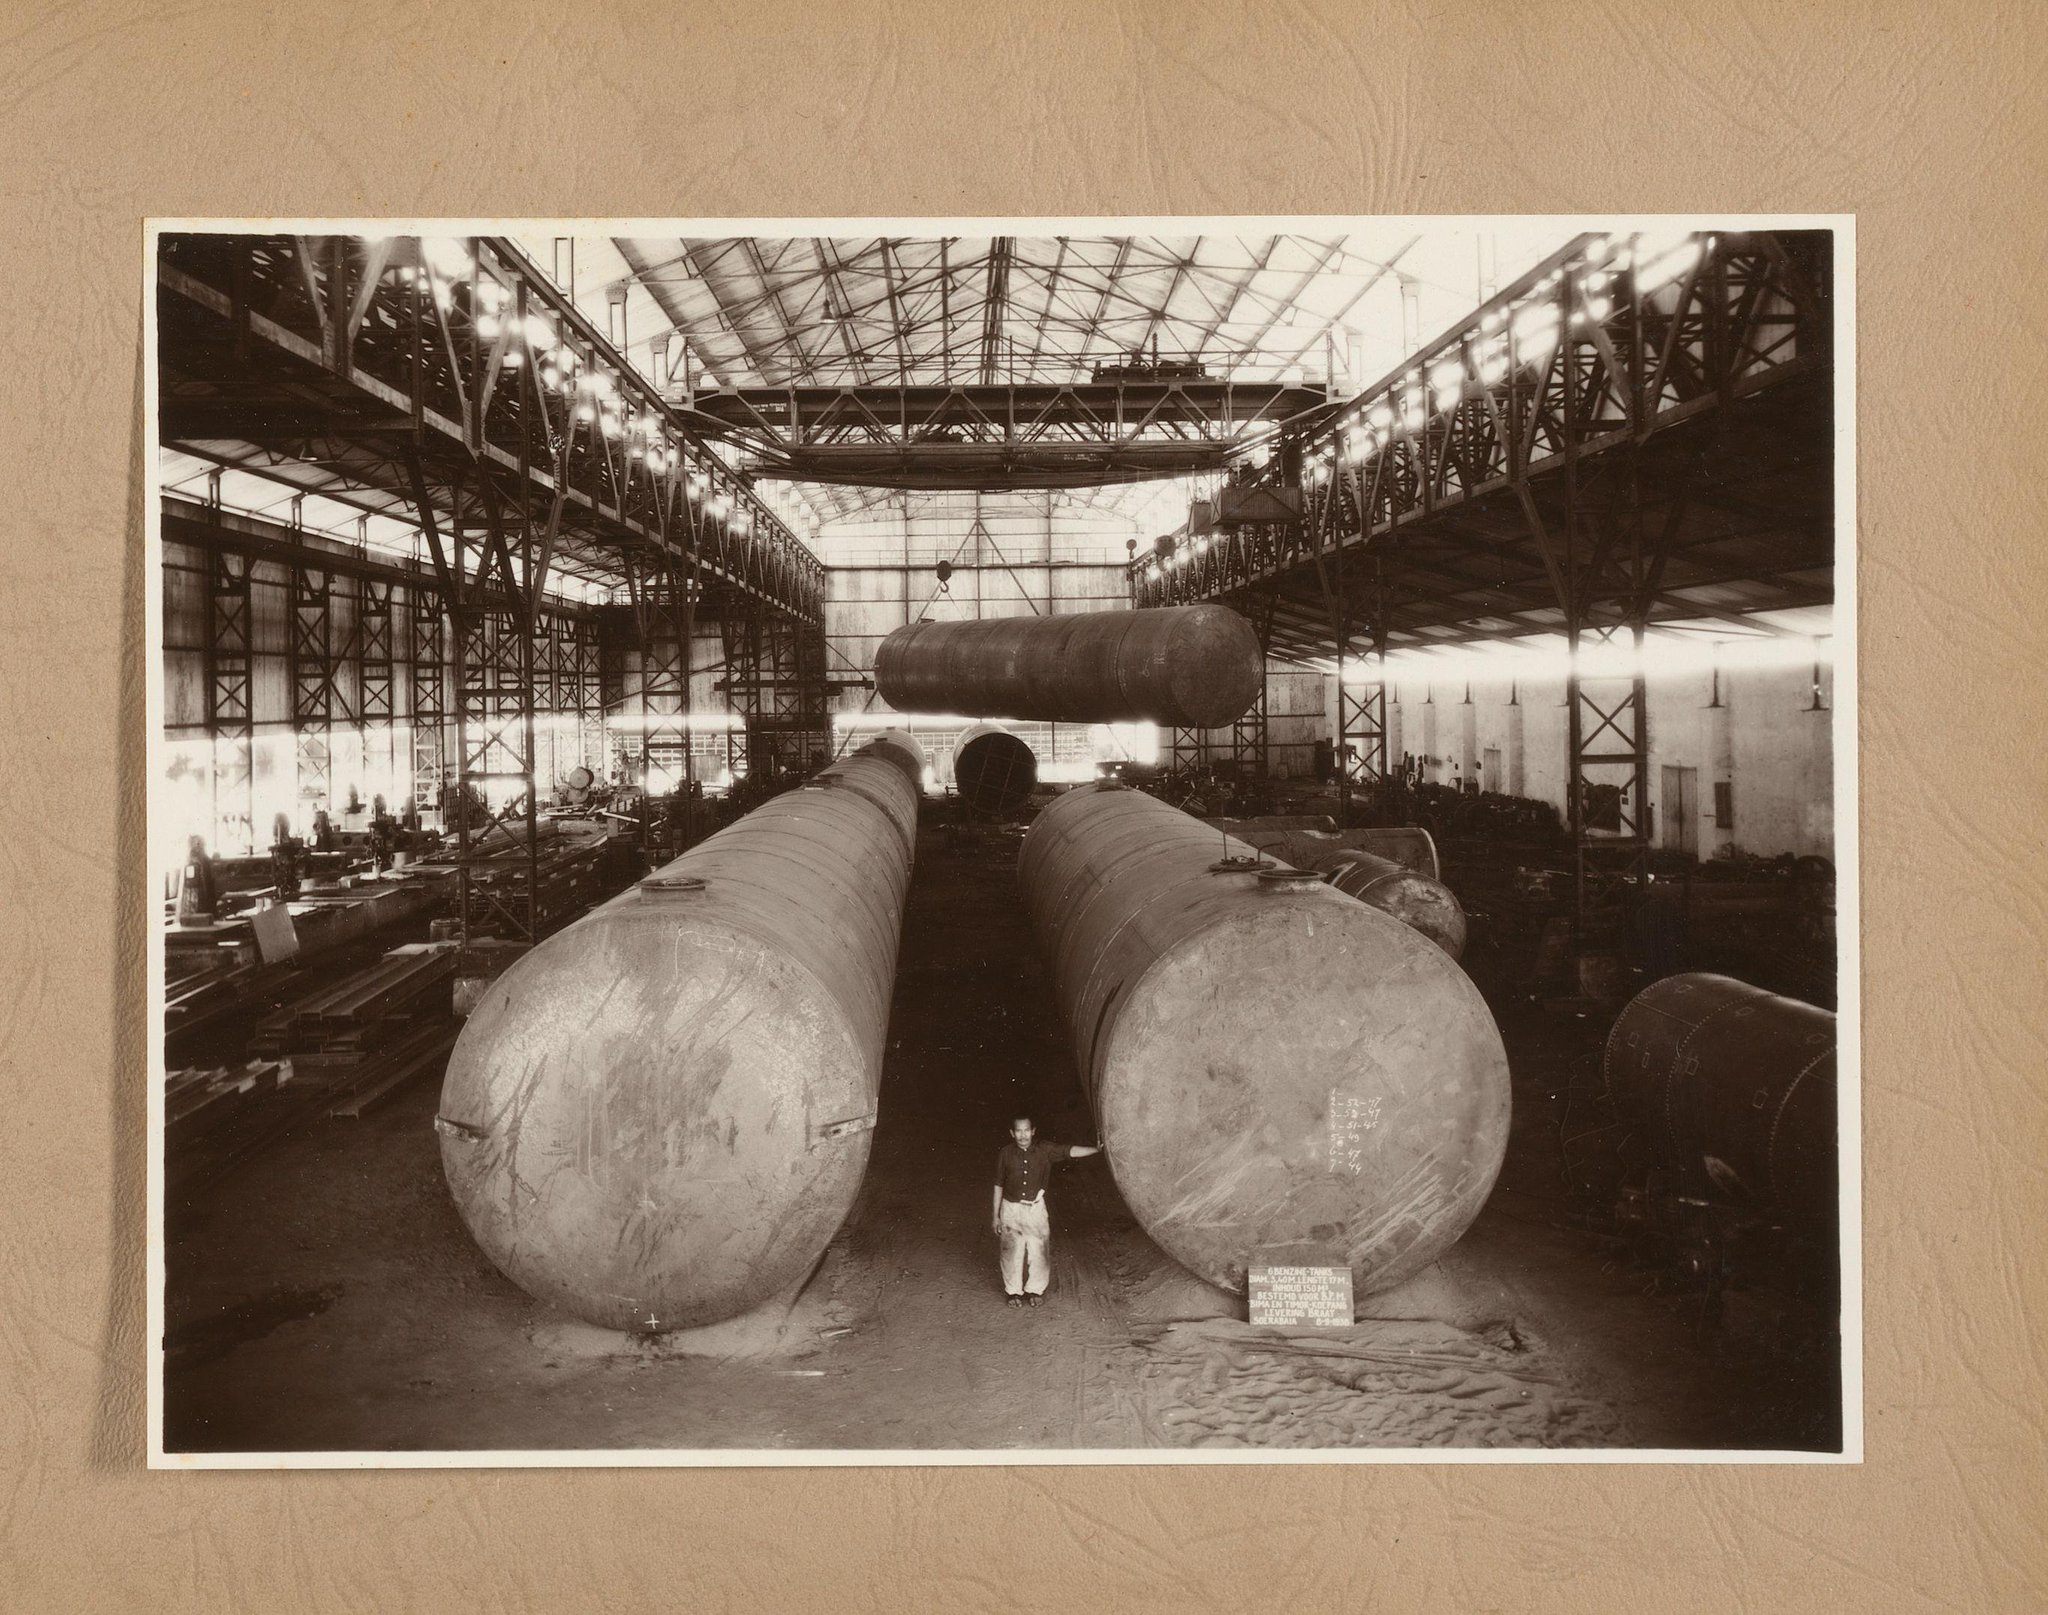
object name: photograph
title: Ondergrondse Benzine-tanks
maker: Anonymous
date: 1938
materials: cardboard, photographic support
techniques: gelatin silver print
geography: surabaya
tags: asiatic races and peoples (indonesians), machines; parts of machines; tools and appliances, interior of industrial structures (regardless of the materials processed or the products made, dutch east indies, the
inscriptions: date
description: Albumblad met een foto van enkele ondergrondse benzinetanks, vervaardigd in 1938 voor de B.P.M. (Bataafsche Petroleum Maatschappij). Een Indische man poseert tussen de tanks. Onderdeel van het fotoalbum van de N.V. Machinefabriek Braat te Soerabaja met foto's van verschillende producten voor de industrie uit de periode 1936-1953.